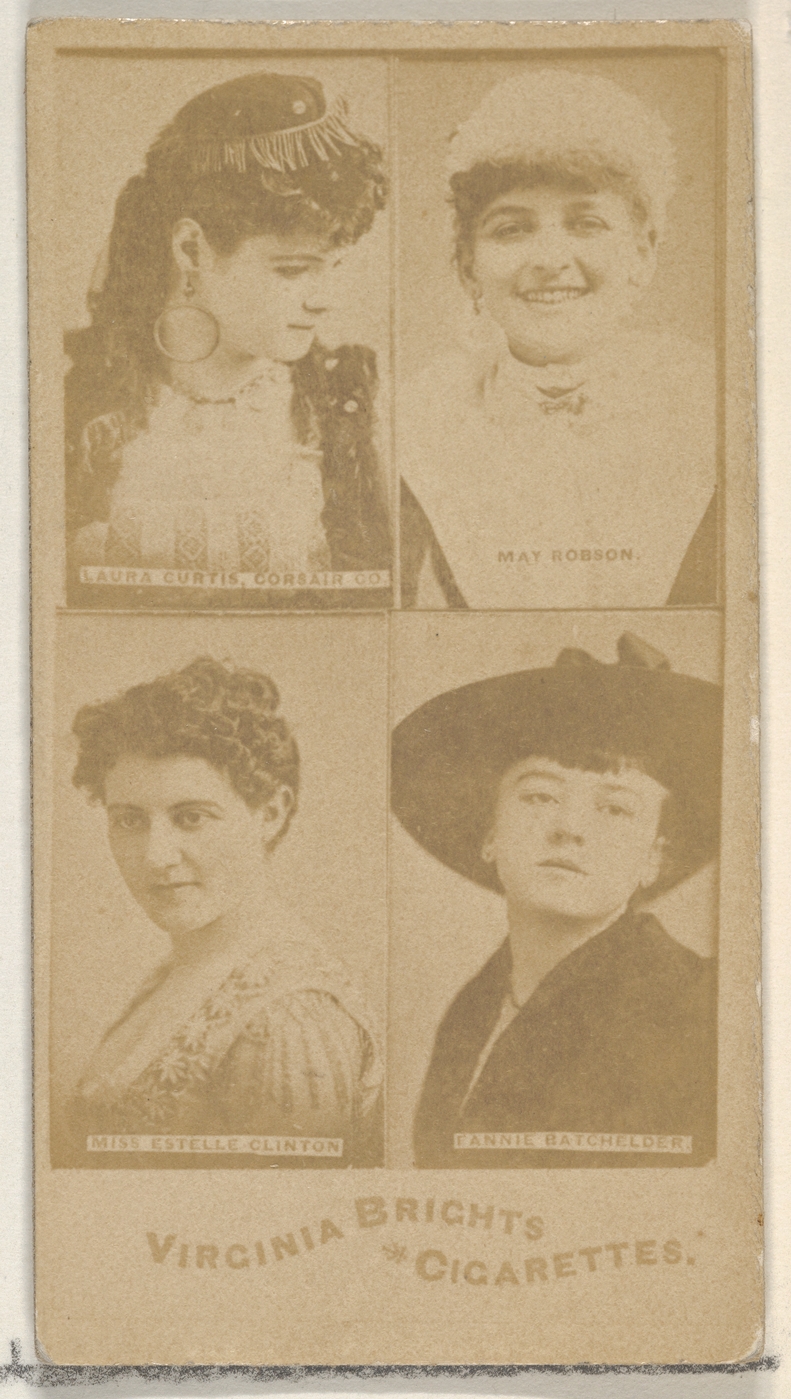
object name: photograph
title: Laura Curtis, Corsair Co./ May Robson/ Miss Estelle Clinton/ Fannie Batchelder, from the Actors and Actresses series (N45, Type 4) for Virginia Brights Cigarettes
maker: allen & ginter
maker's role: publisher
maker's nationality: american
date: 1888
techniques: albumen silver print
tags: portraits,women,actresses